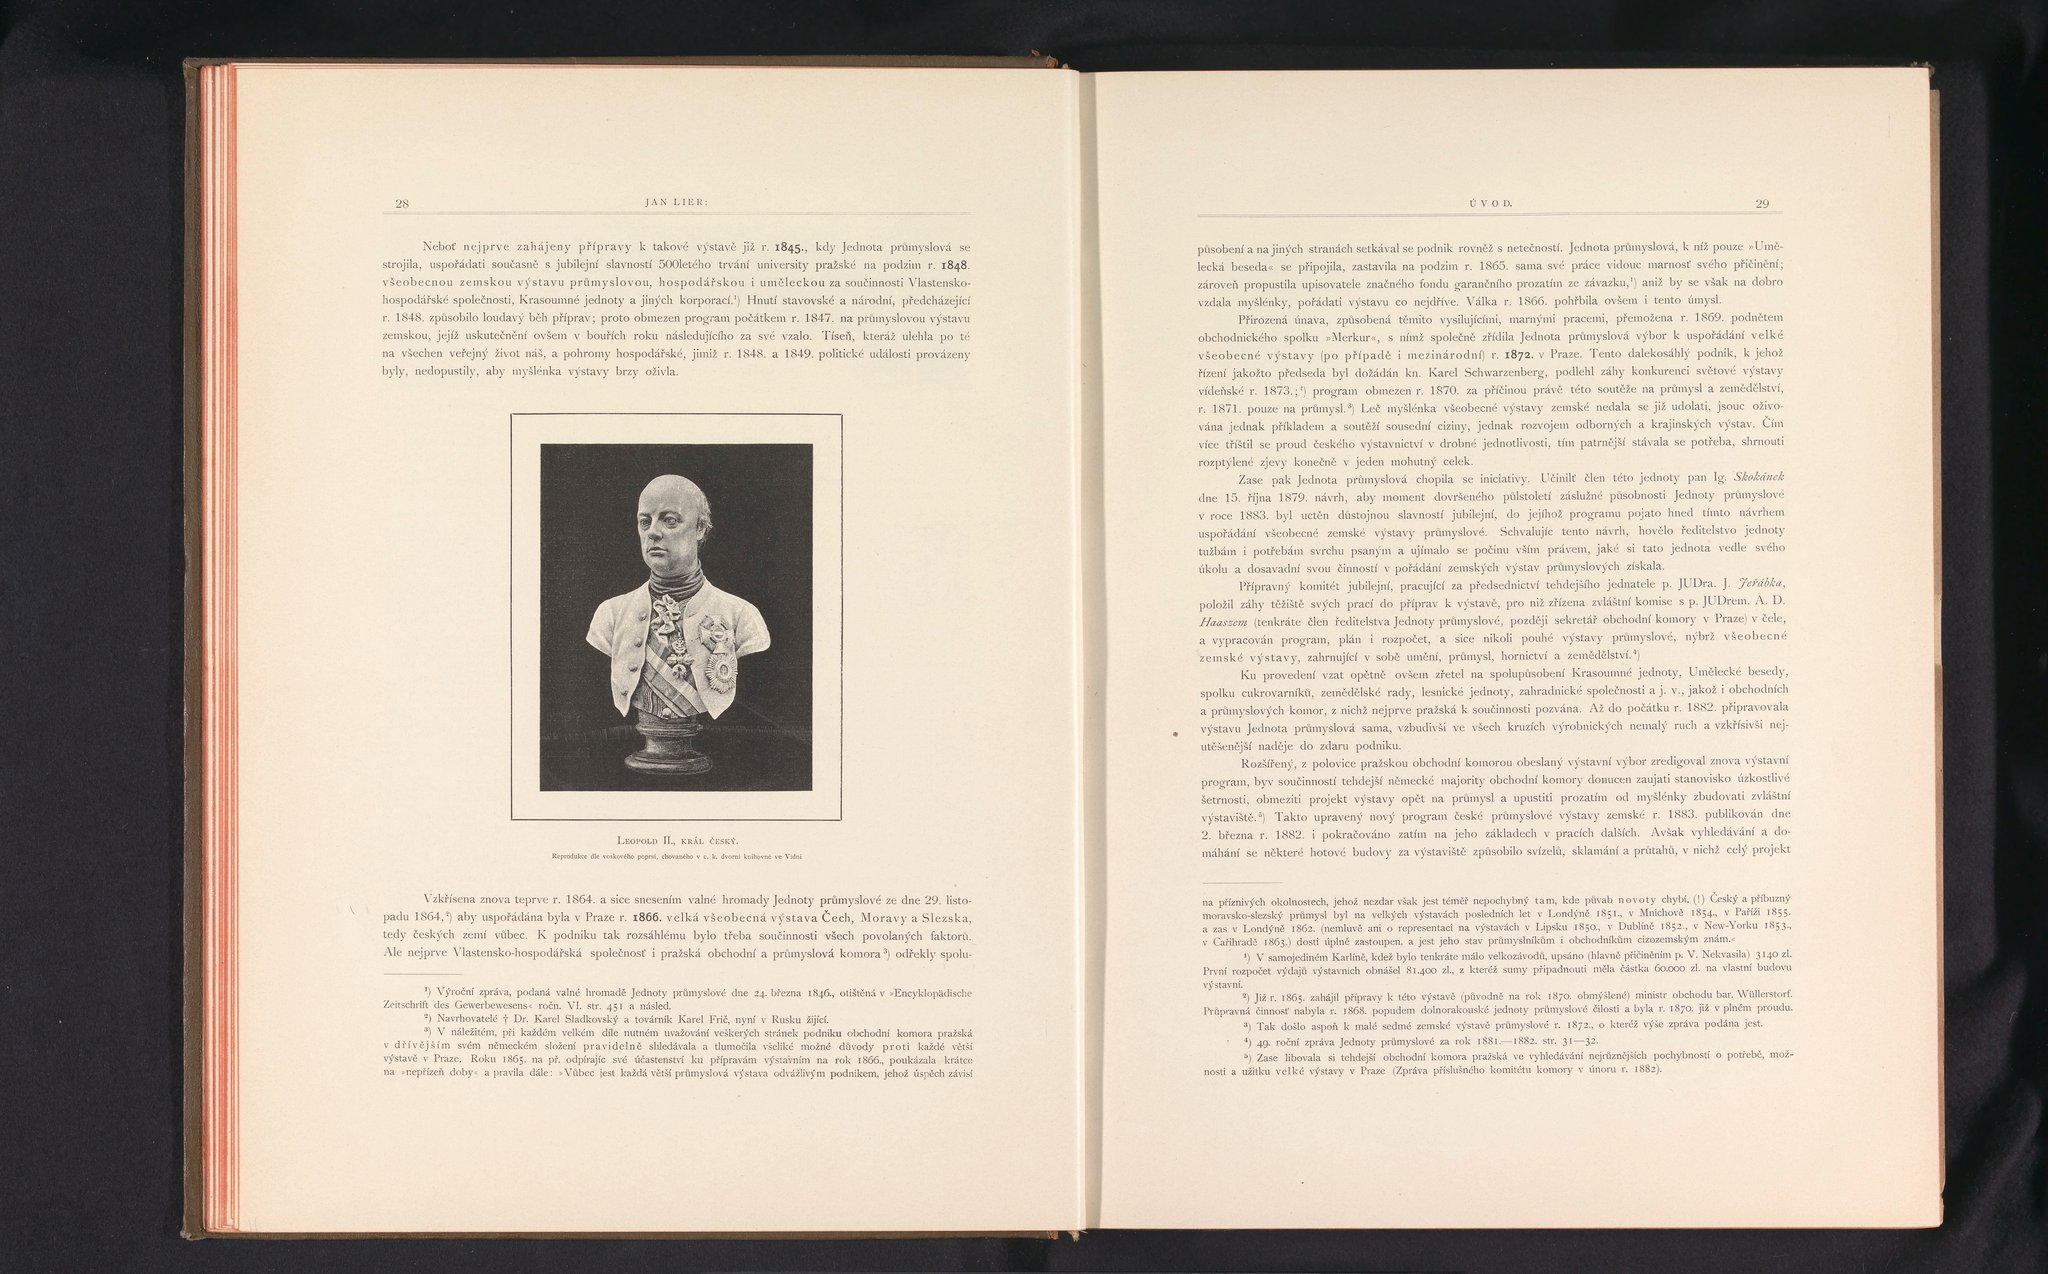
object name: photomechanical print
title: Leopold II, Král Ceský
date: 1888-1893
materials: paper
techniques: autotype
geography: prague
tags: chest, bust, emperor